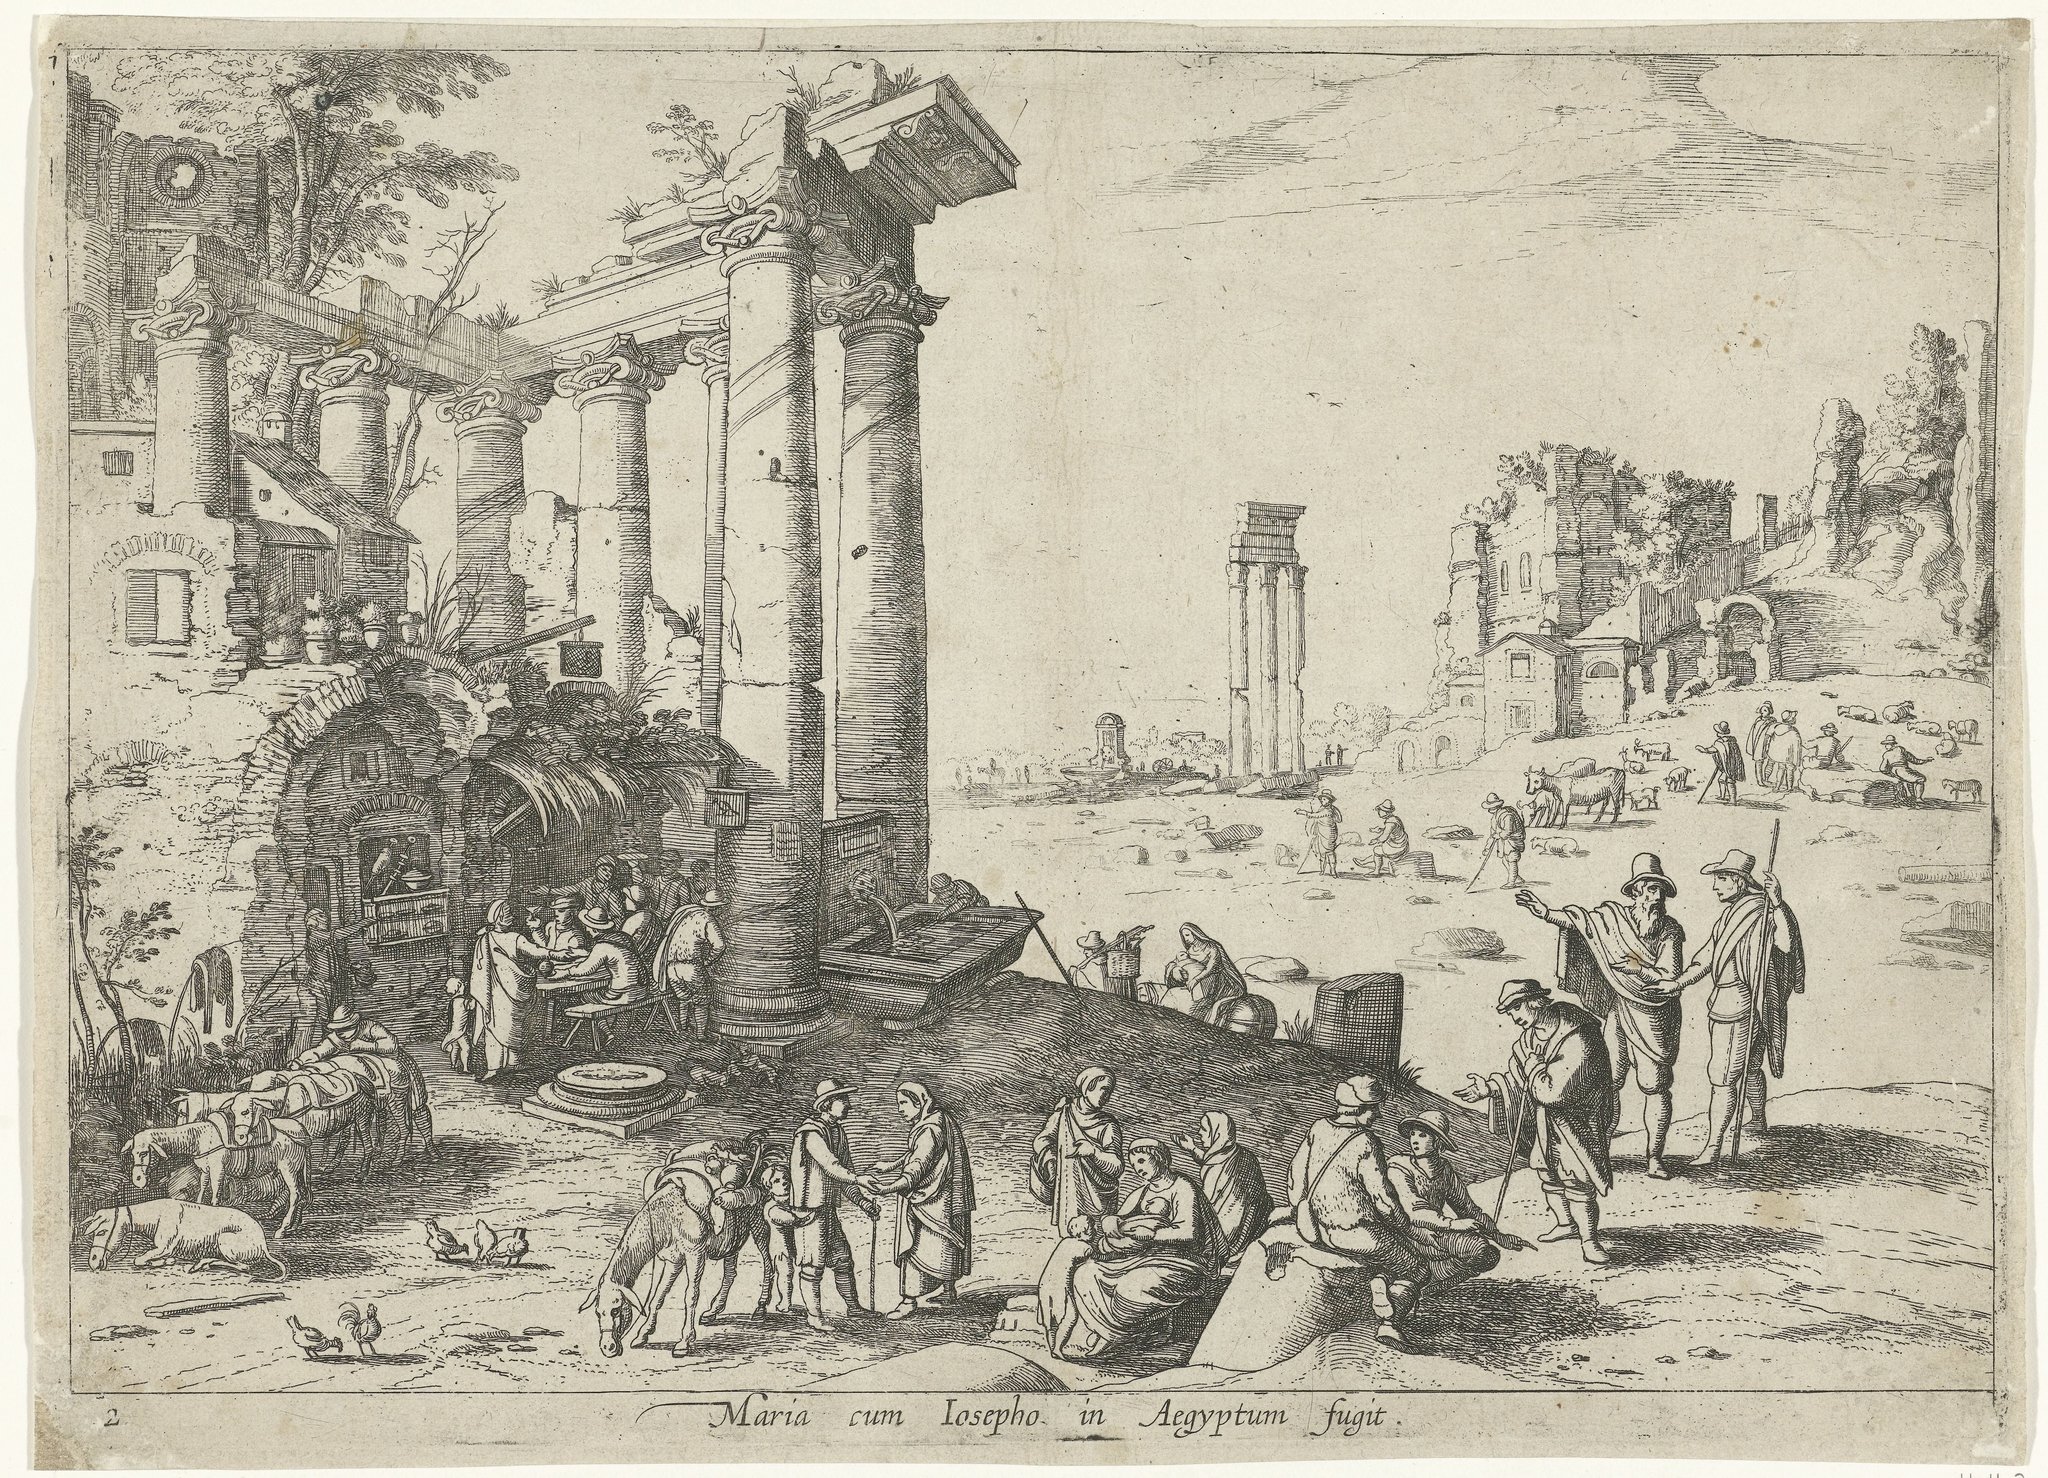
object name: print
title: Italiaanse landschappen met Bijbelse voorstellingen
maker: guilliam van nieulandt (ii)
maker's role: draughtsman, print maker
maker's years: 1584-1635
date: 1606-1628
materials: paper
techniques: etching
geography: antwerp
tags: the flight into egypt: mary, joseph, the child (and sometimes others) on their way; mary usually riding on an ass, inn, coffee-house, public house, etc., landscape with ruins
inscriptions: collector's mark: Lugt 2228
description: In een Italiaans landschap ligt links tussen de resten van een klassieke tempel een herberg. Daarvoor zitten en staan verschillende figuren en ezels. In het midden achter een kleine heuvel loopt Jozef met een mand aan de schouder voor de ezel, die Maria met kind draagt, uit. Op de achtergrond klassieke ruïnes, waaronder de drie zuilen van de tempel van Castor en Pollux op het Forum Romanum te Rome.